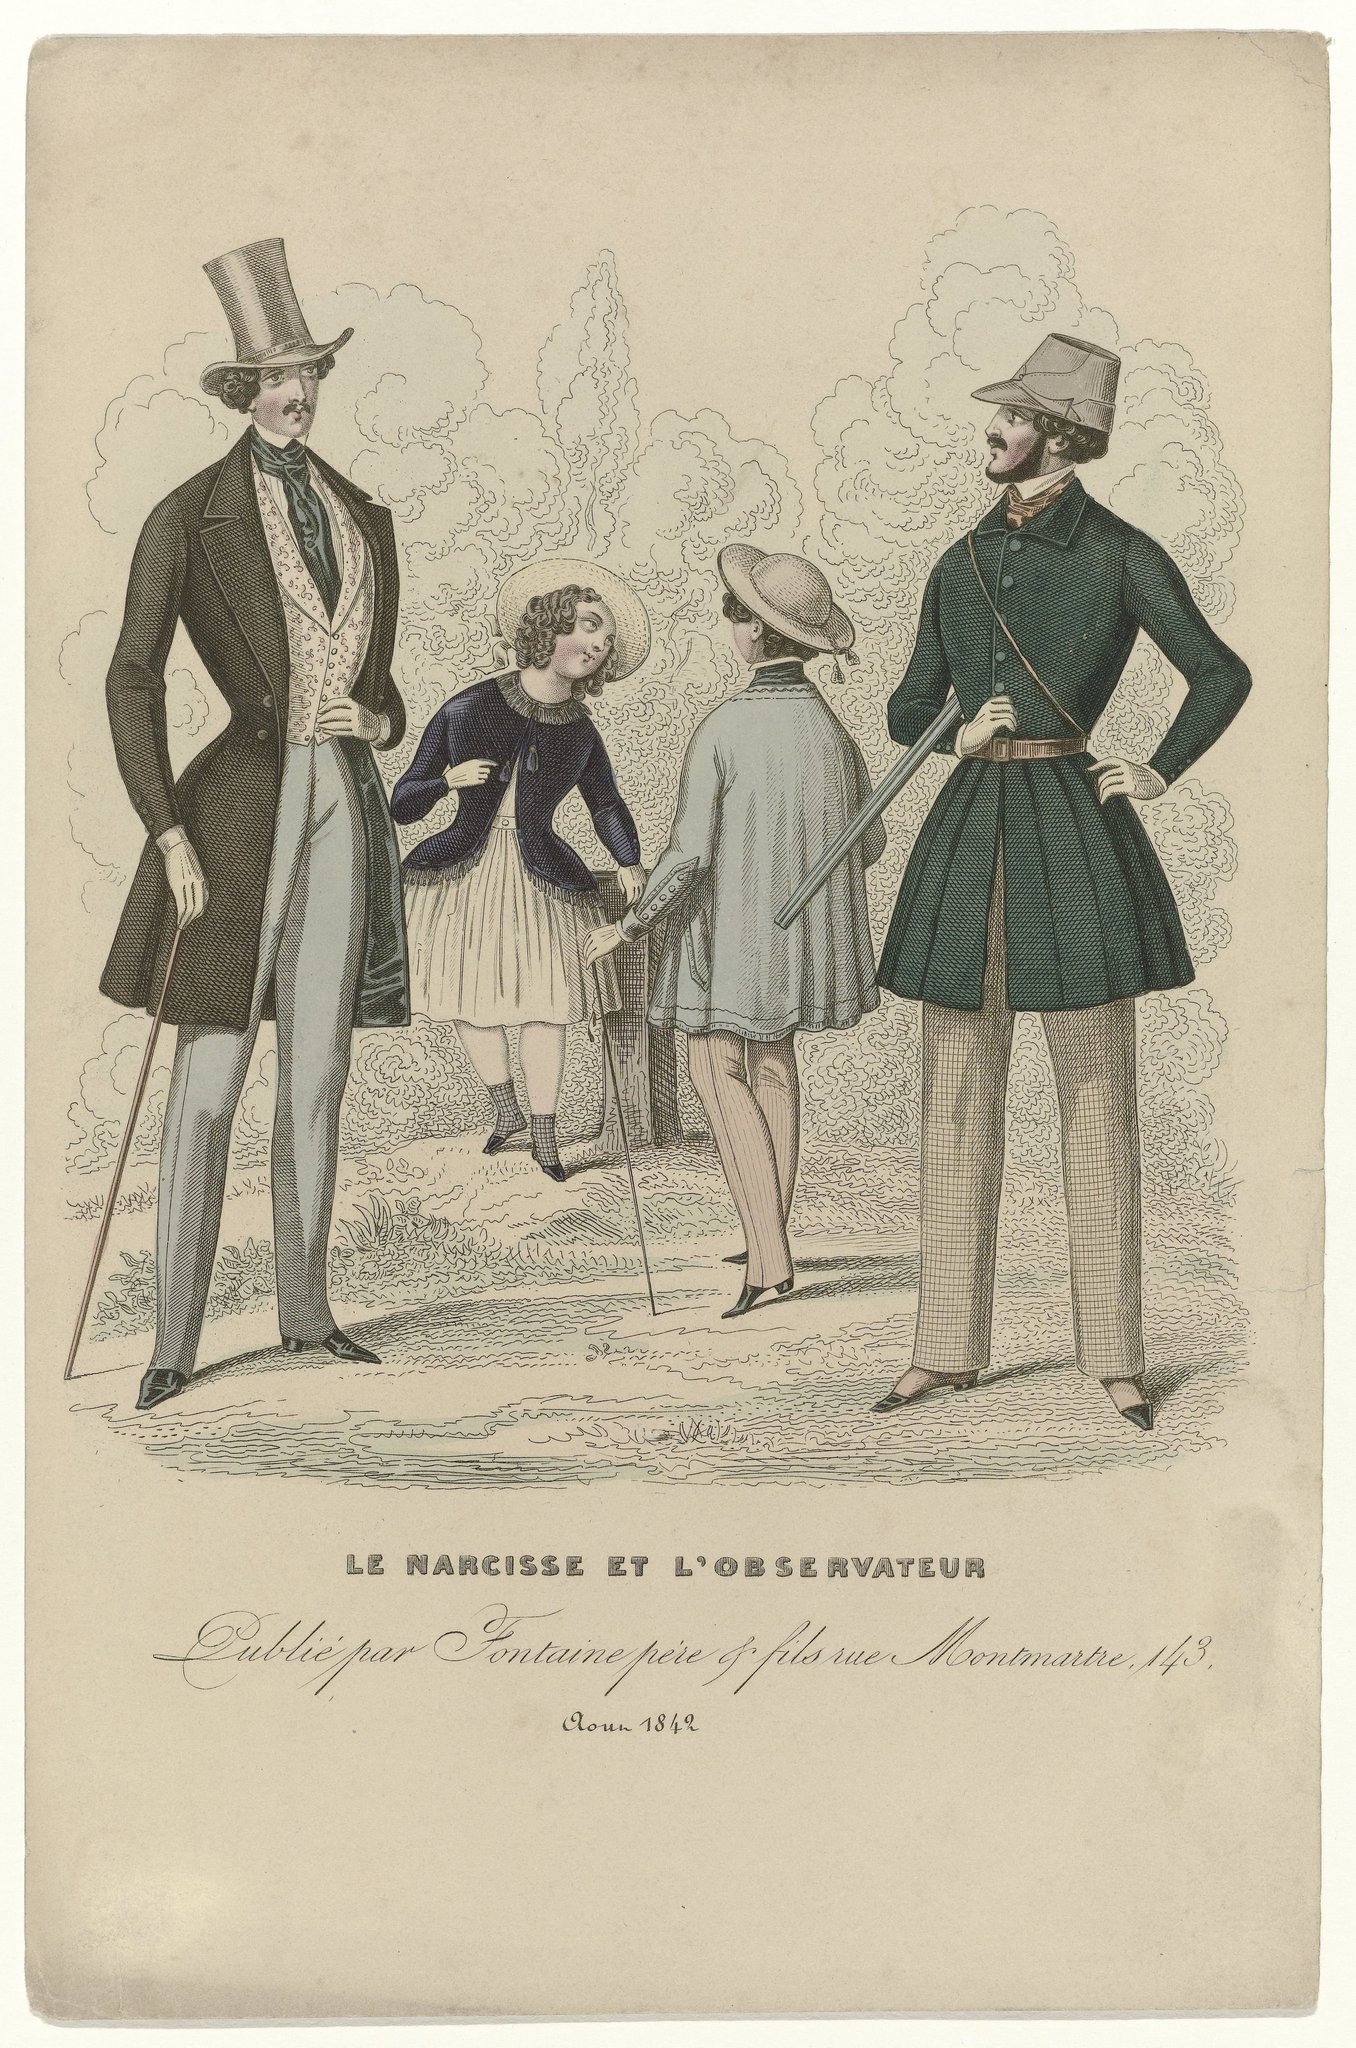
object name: fashion print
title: Le Narcisse et l'observateur, août 1842 : Publié par Fontain (...)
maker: Anonymous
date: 1842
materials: paper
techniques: engraving, hand coloring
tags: hunter (+ hunting weapons, equipment, outfit), skirt (+ girls' clothes), neck-gear ~ clothing (+ men's clothes), trousers, breeches, etc. (pantalon) (+ men's clothes), head-gear (+ girls' clothes), clothing for the upper part of the body (+ girls' clothes), ensembles of pieces of clothing (hunting costume) (+ men's clothes), coat (+ men's clothes), hunter, fashion plates, shoes, sandals (+ men's clothes), gloves, mittens, etc. (+ men's clothes), walking-stick, staff, cane (+ men's clothes)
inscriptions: address: ‘Publié par Fontaine père & fils rue Montmartre, 143. / Aout 1842’, title: ‘Le Narcisse et l'observateur’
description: Twee mannen, van wie één met een geweer onder de arm. Op de achtergrond twee kinderen, van wie de jongen op de rug is weergegeven. Links: jas, vest en lange spanbroek. Geknoopte zwarte halsdoek. Accessoires: hoge hoed, handschoenen, wandelstok, schoenen met vierkante neuzen en hakken. Rechts: jachtkostuum, bestaande uit een jas met ceintuur op een geruite lange broek. Het meisje draagt een jasje met lange mouwen en afgeronde voorpanden op een wijde witte rok. De jongen draagt een wijde jas op een lange broek. Wandelstok in de hand. Prent uit het modetijdschrift Le Narcisse et l'observateur (1829-1855)